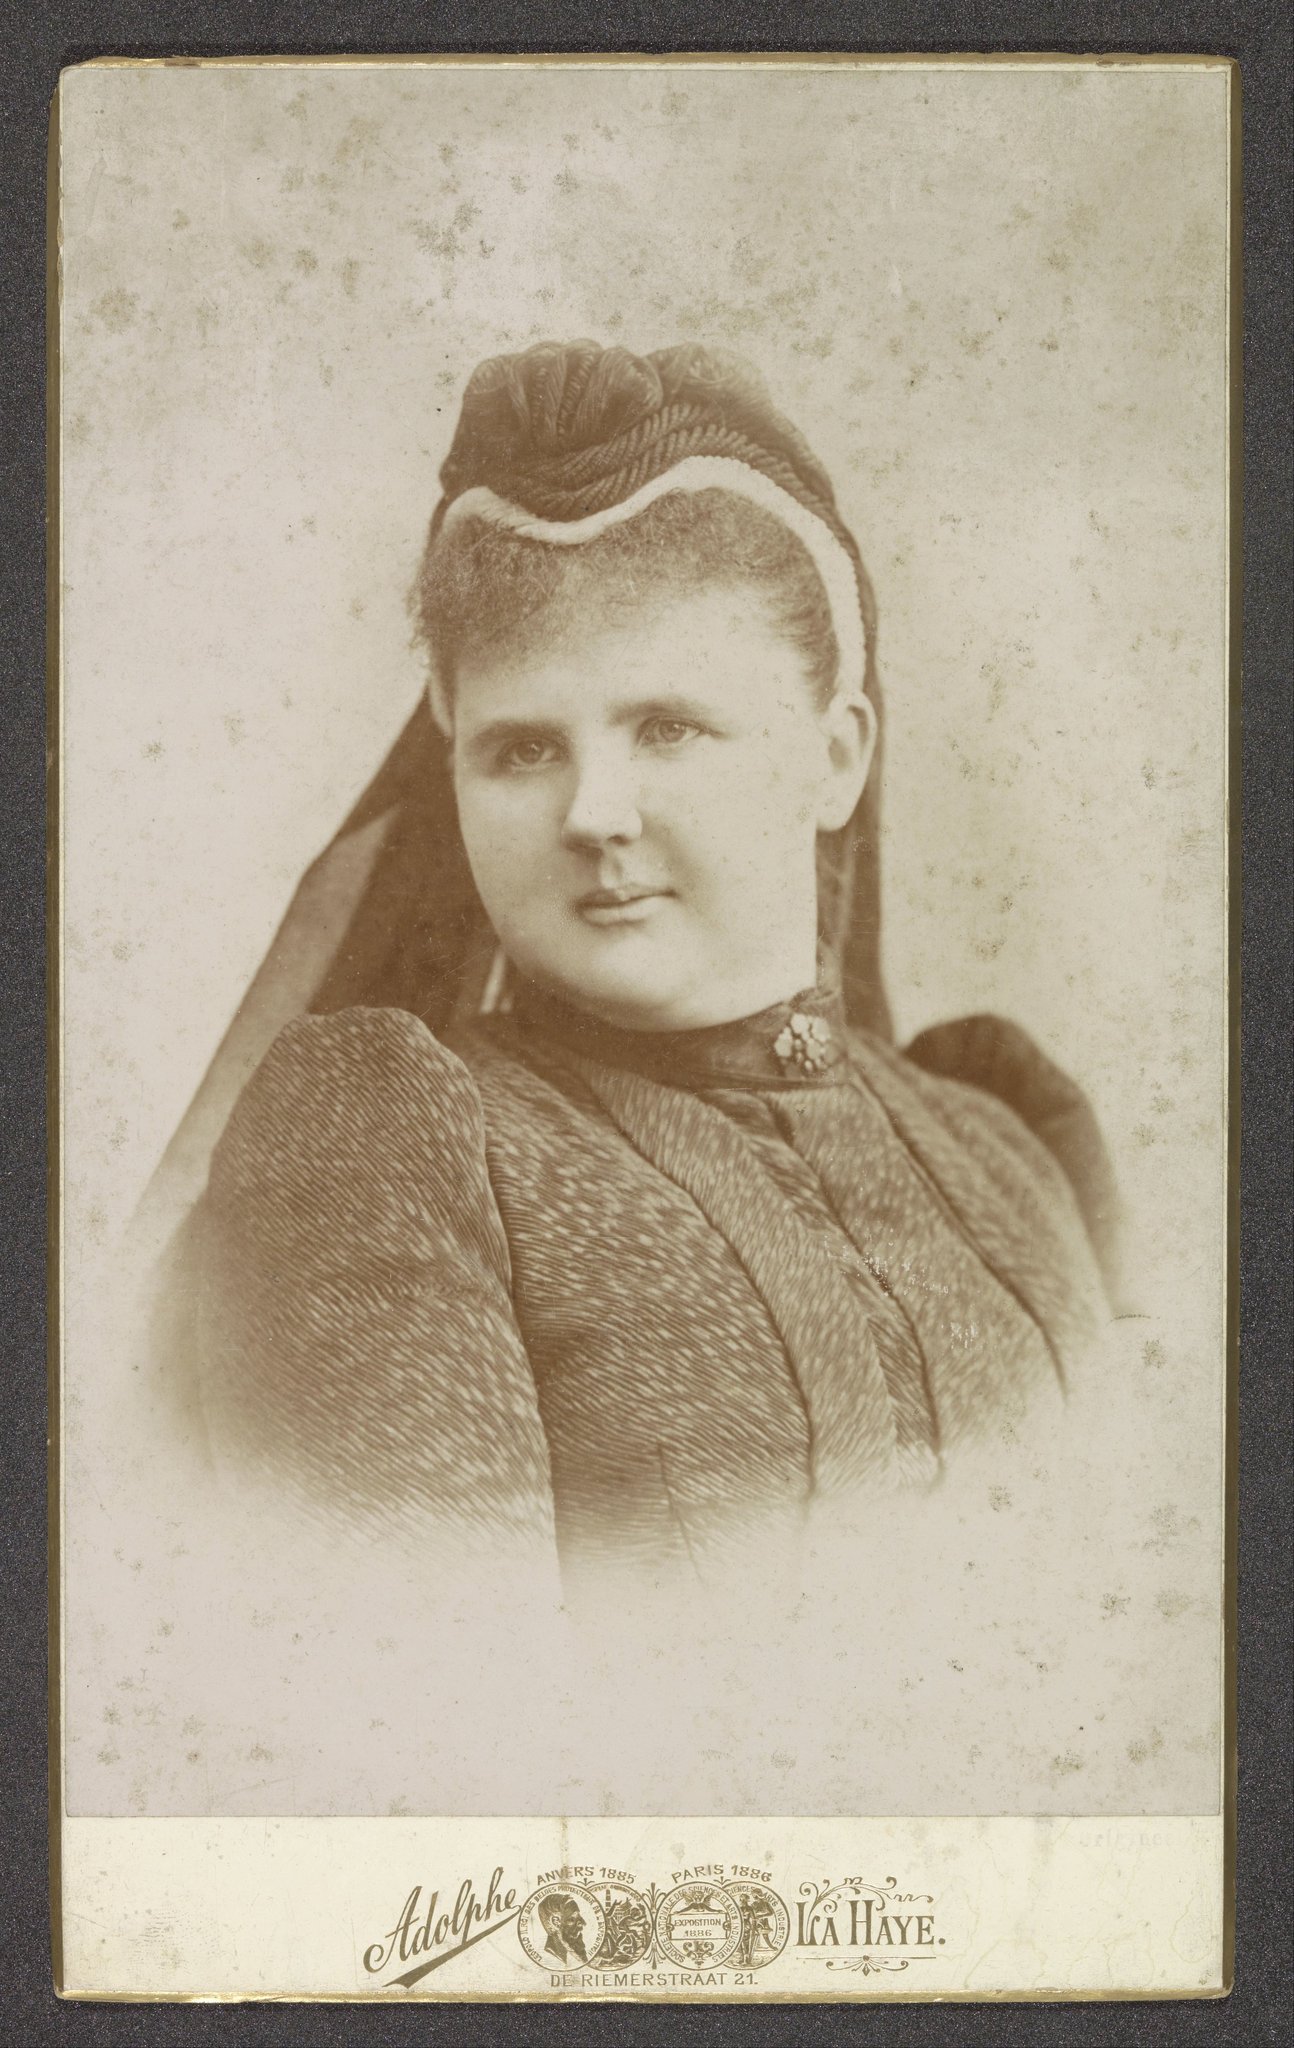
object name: photograph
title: portret van Koningin Emma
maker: adolphe zimmermans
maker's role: fotograaf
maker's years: 1858-1922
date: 1891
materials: cardboard, photographic support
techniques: albumen print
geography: the hague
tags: emma (queen consort of the netherlands)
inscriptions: signature: ‘Adolphe Anvers 1885 Paris 1886 De Riemerstraat 21 La Haye’